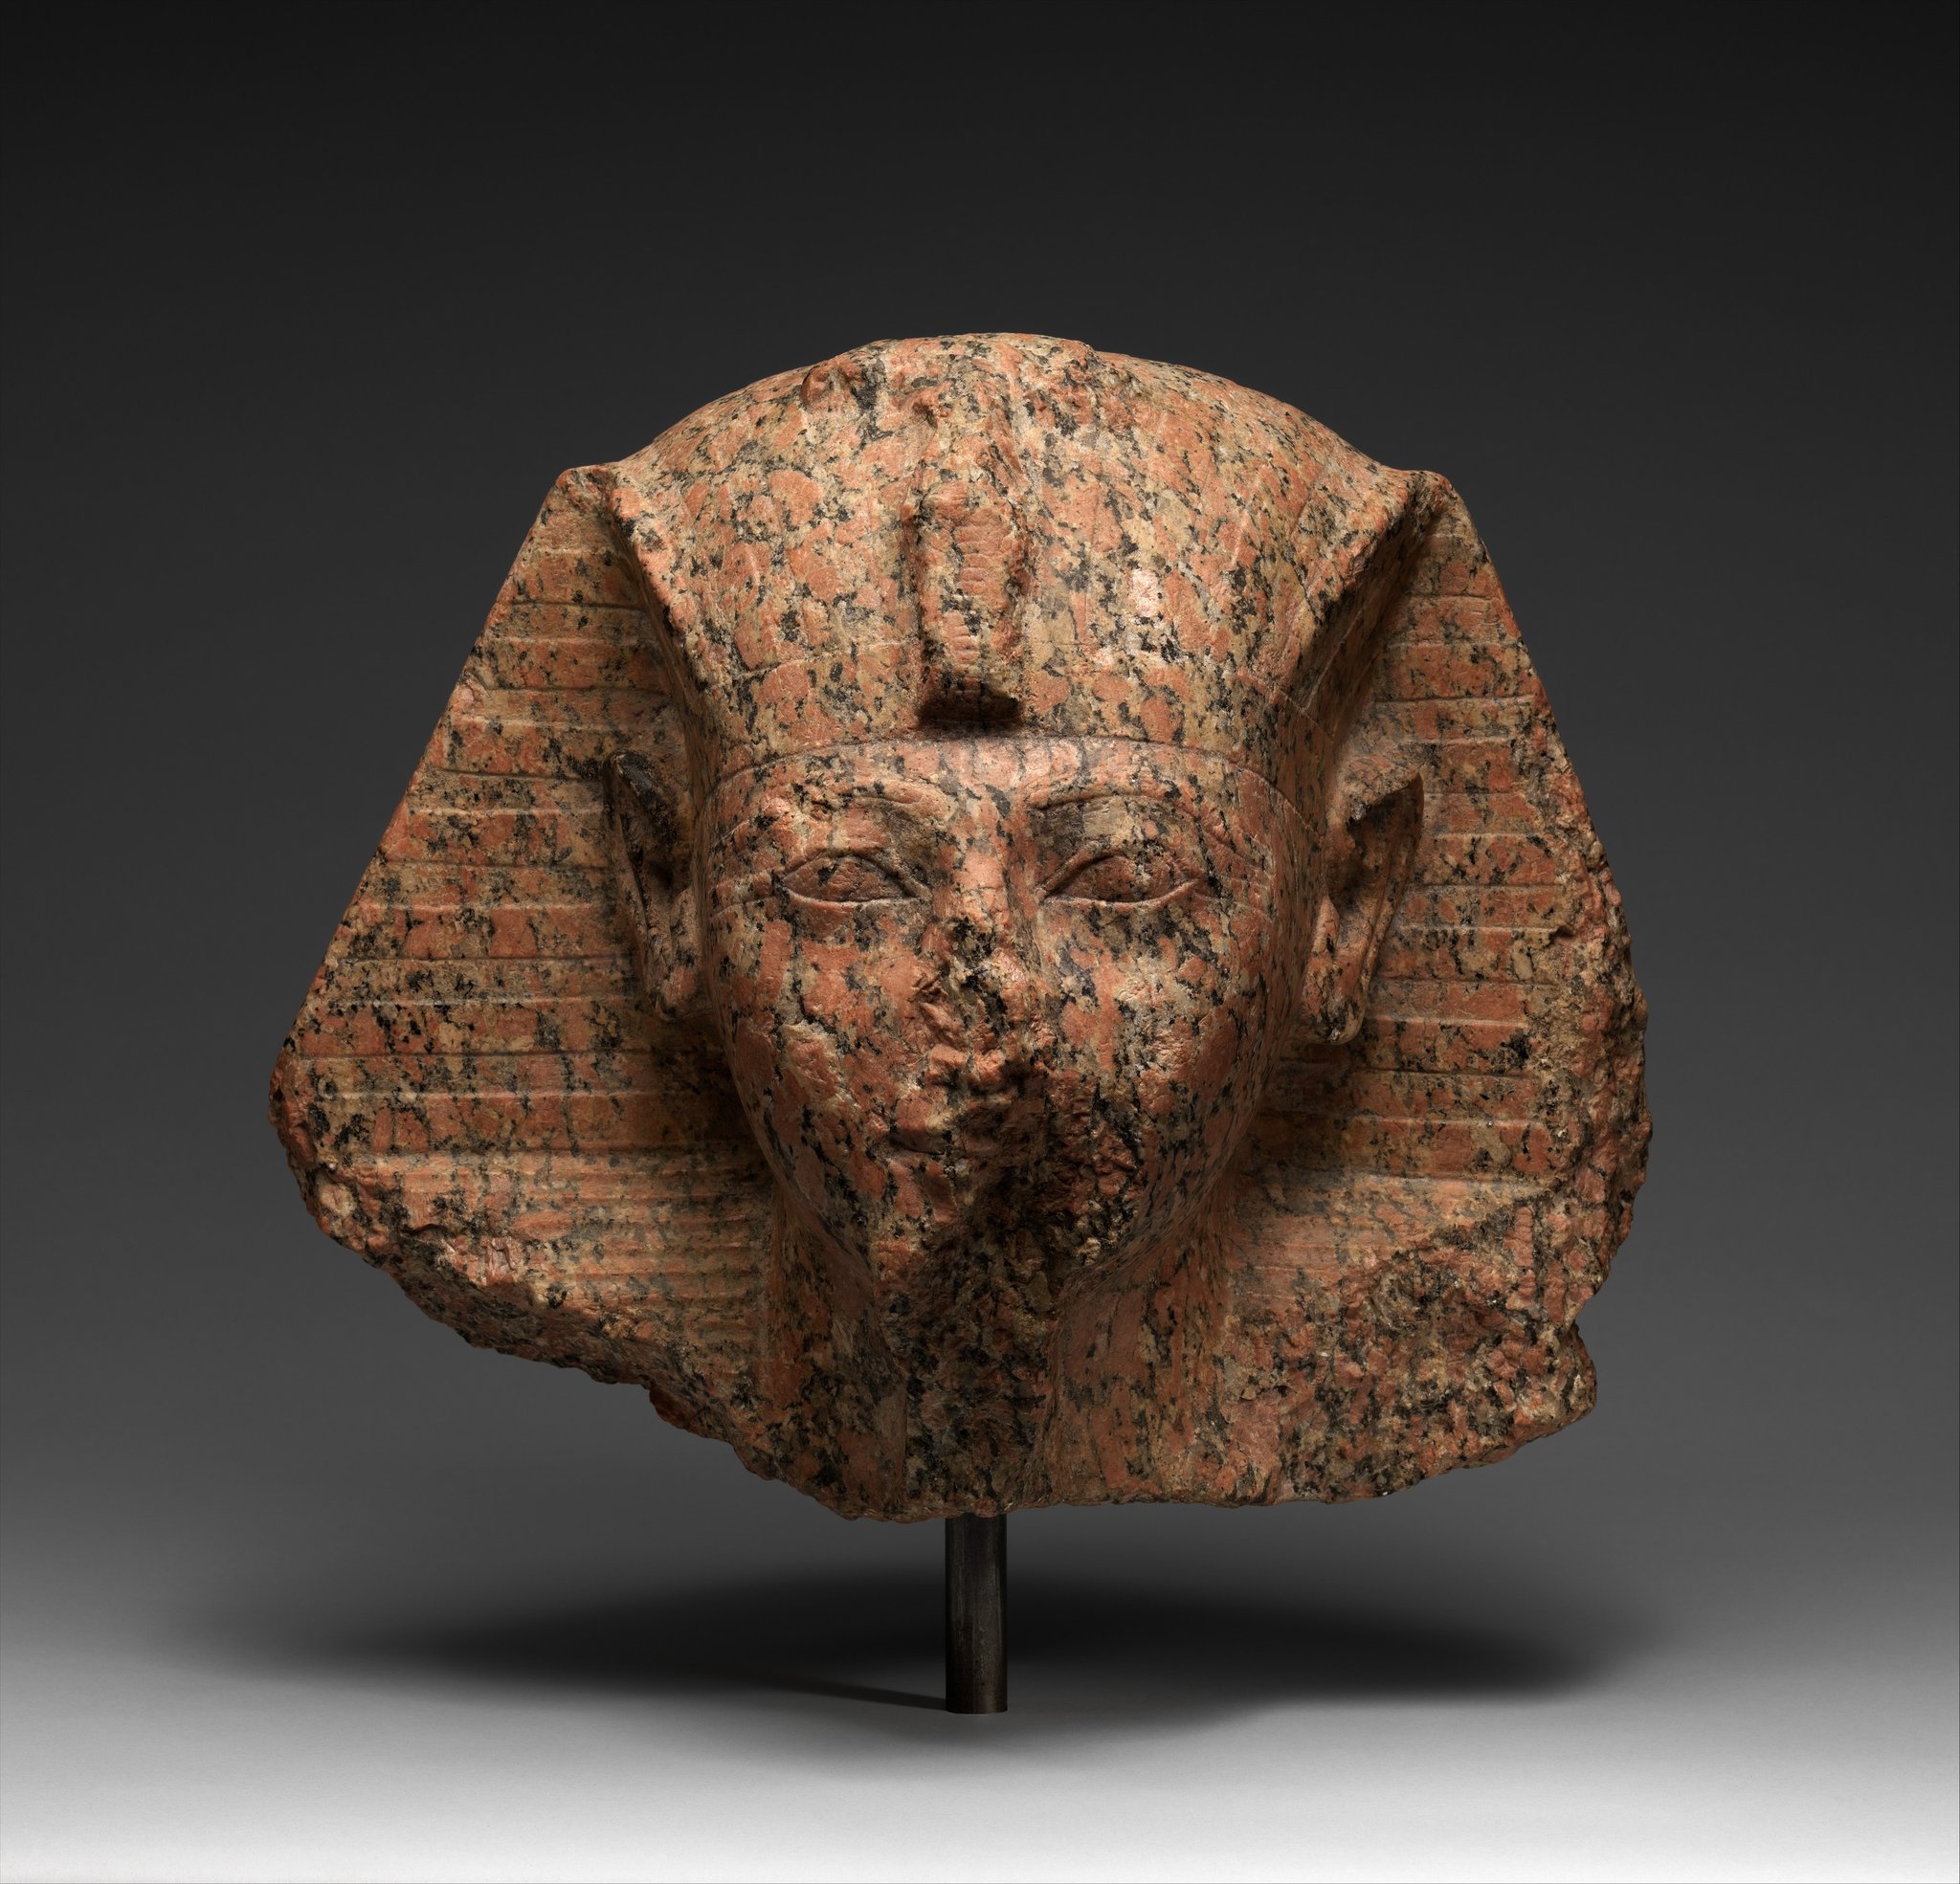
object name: head, royal, hatshepsut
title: Head of Hatshepsut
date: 1479-1458 BCE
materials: granite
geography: egypt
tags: kings,heads